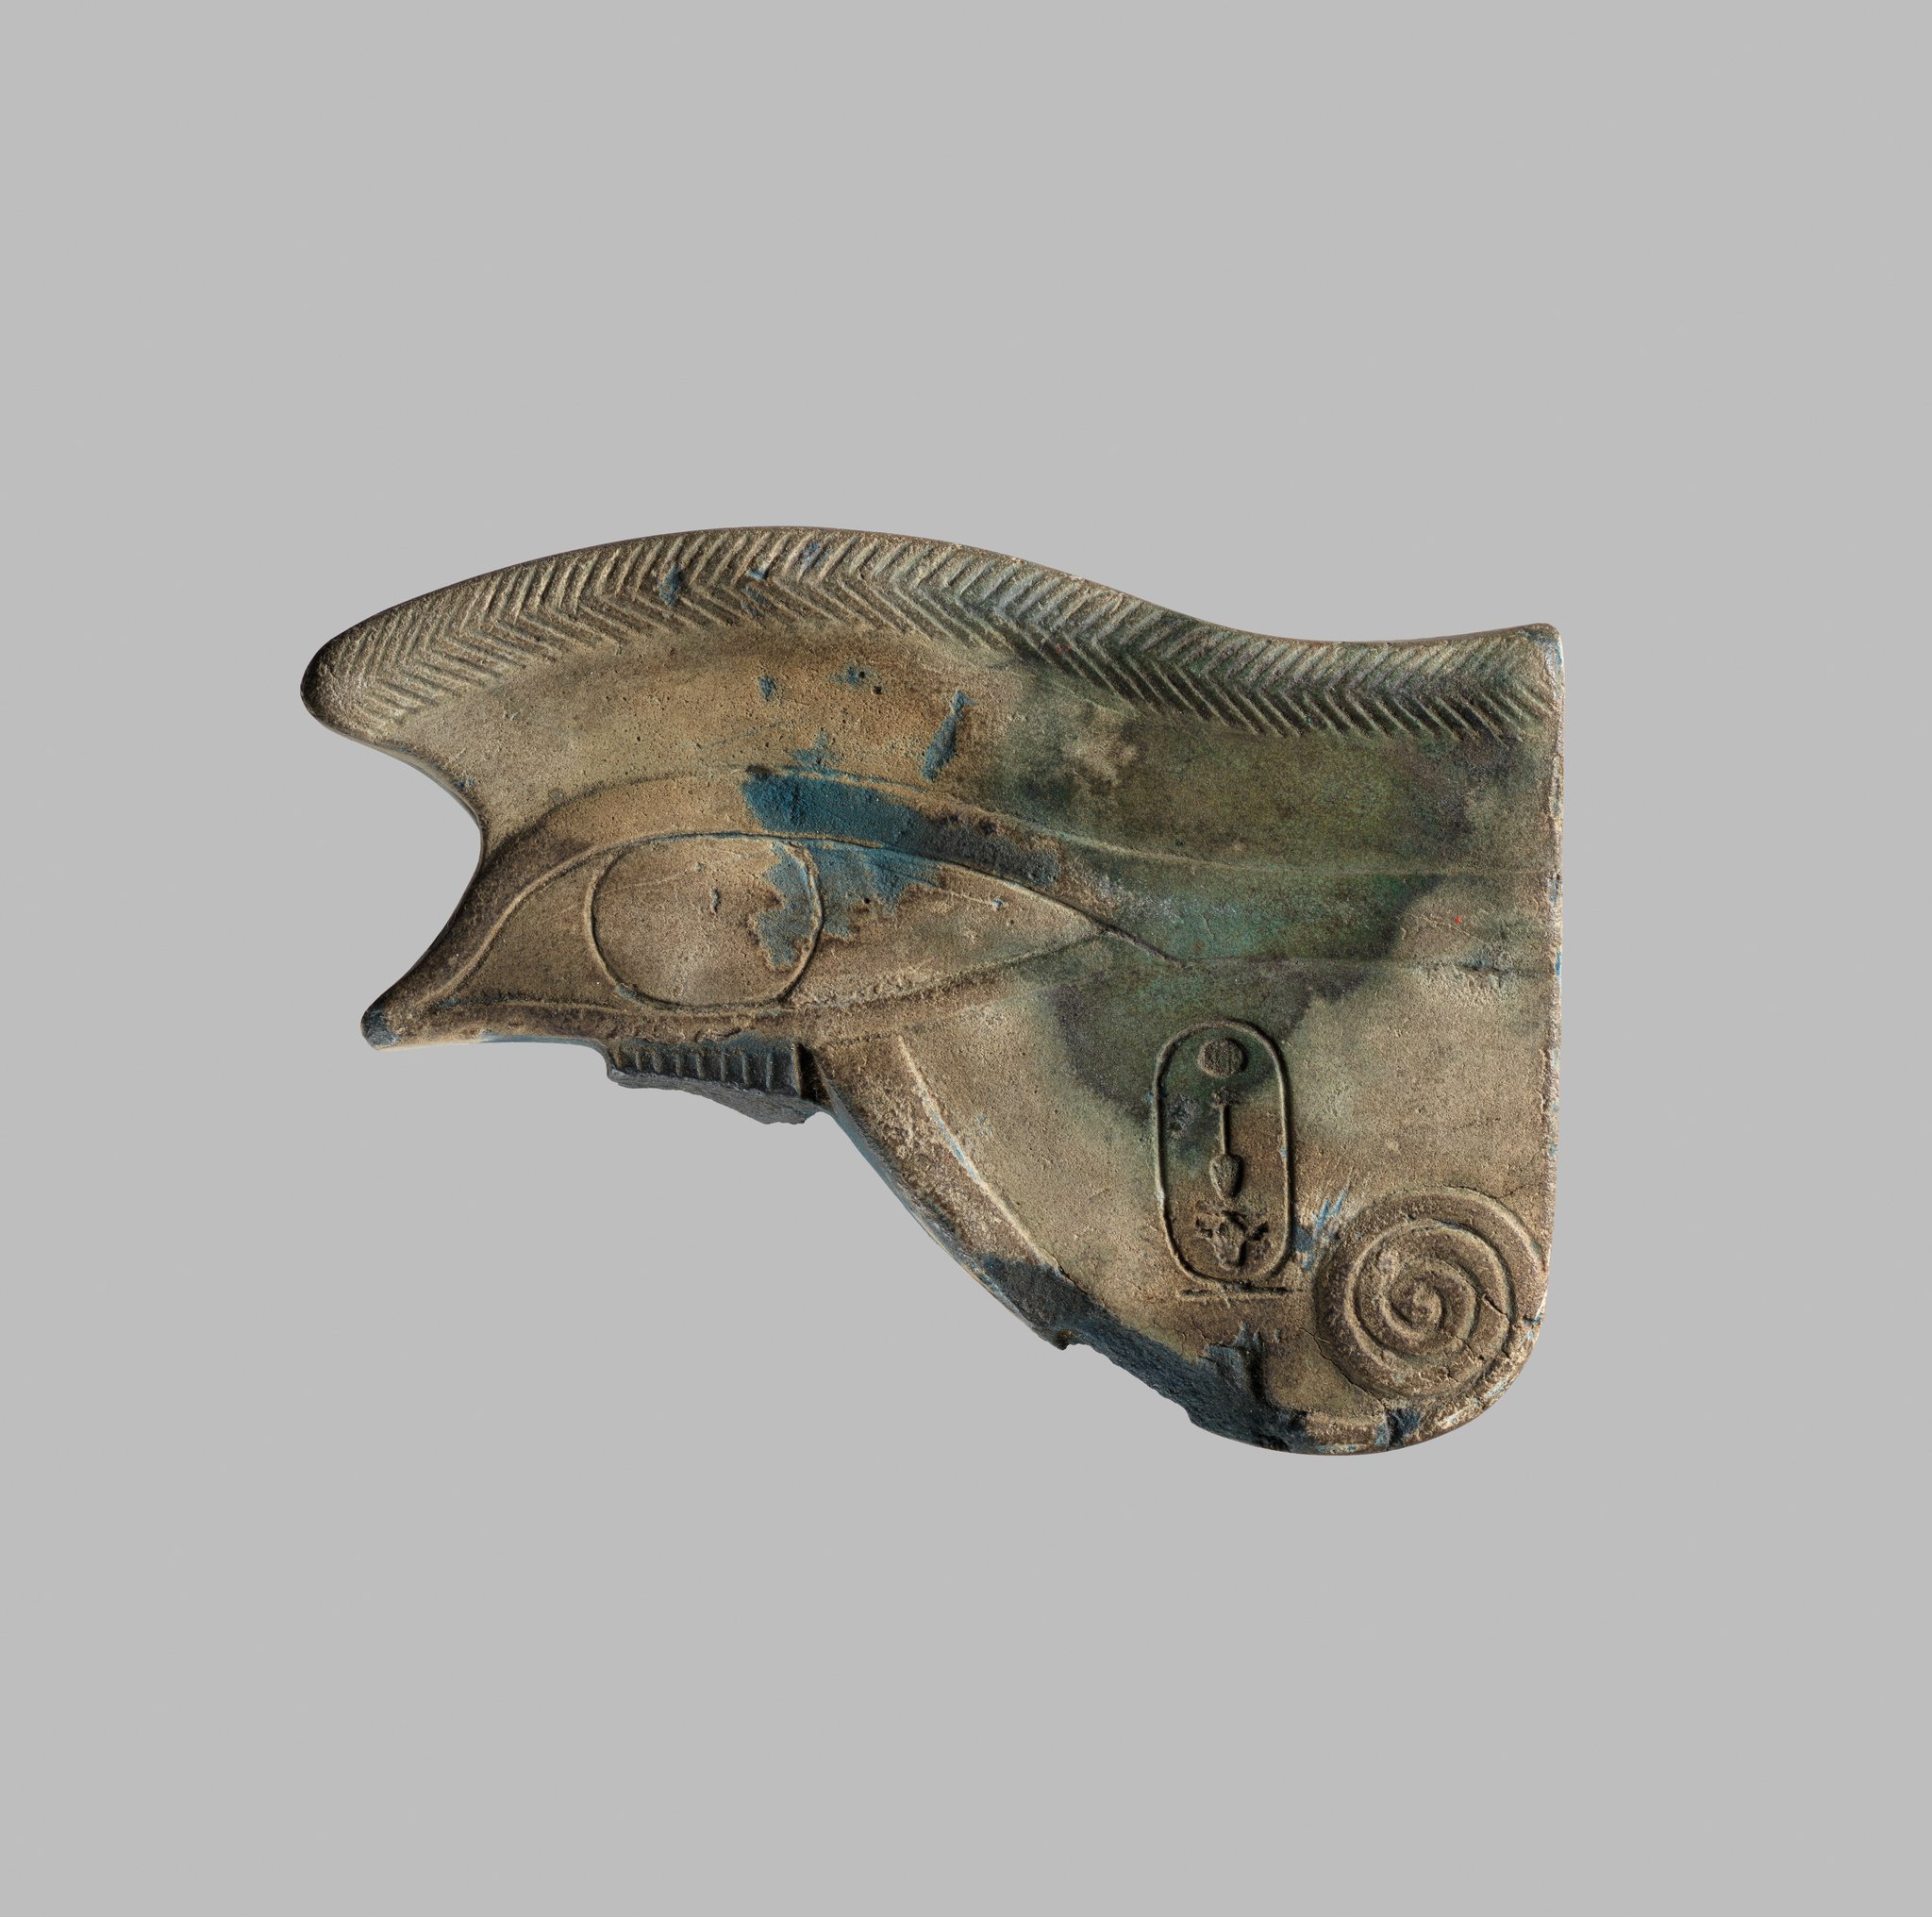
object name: amulet, wedjat eye, psamtik ii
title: Wedjat Eye Amulet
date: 598-595 BCE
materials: limestone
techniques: glazing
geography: egypt